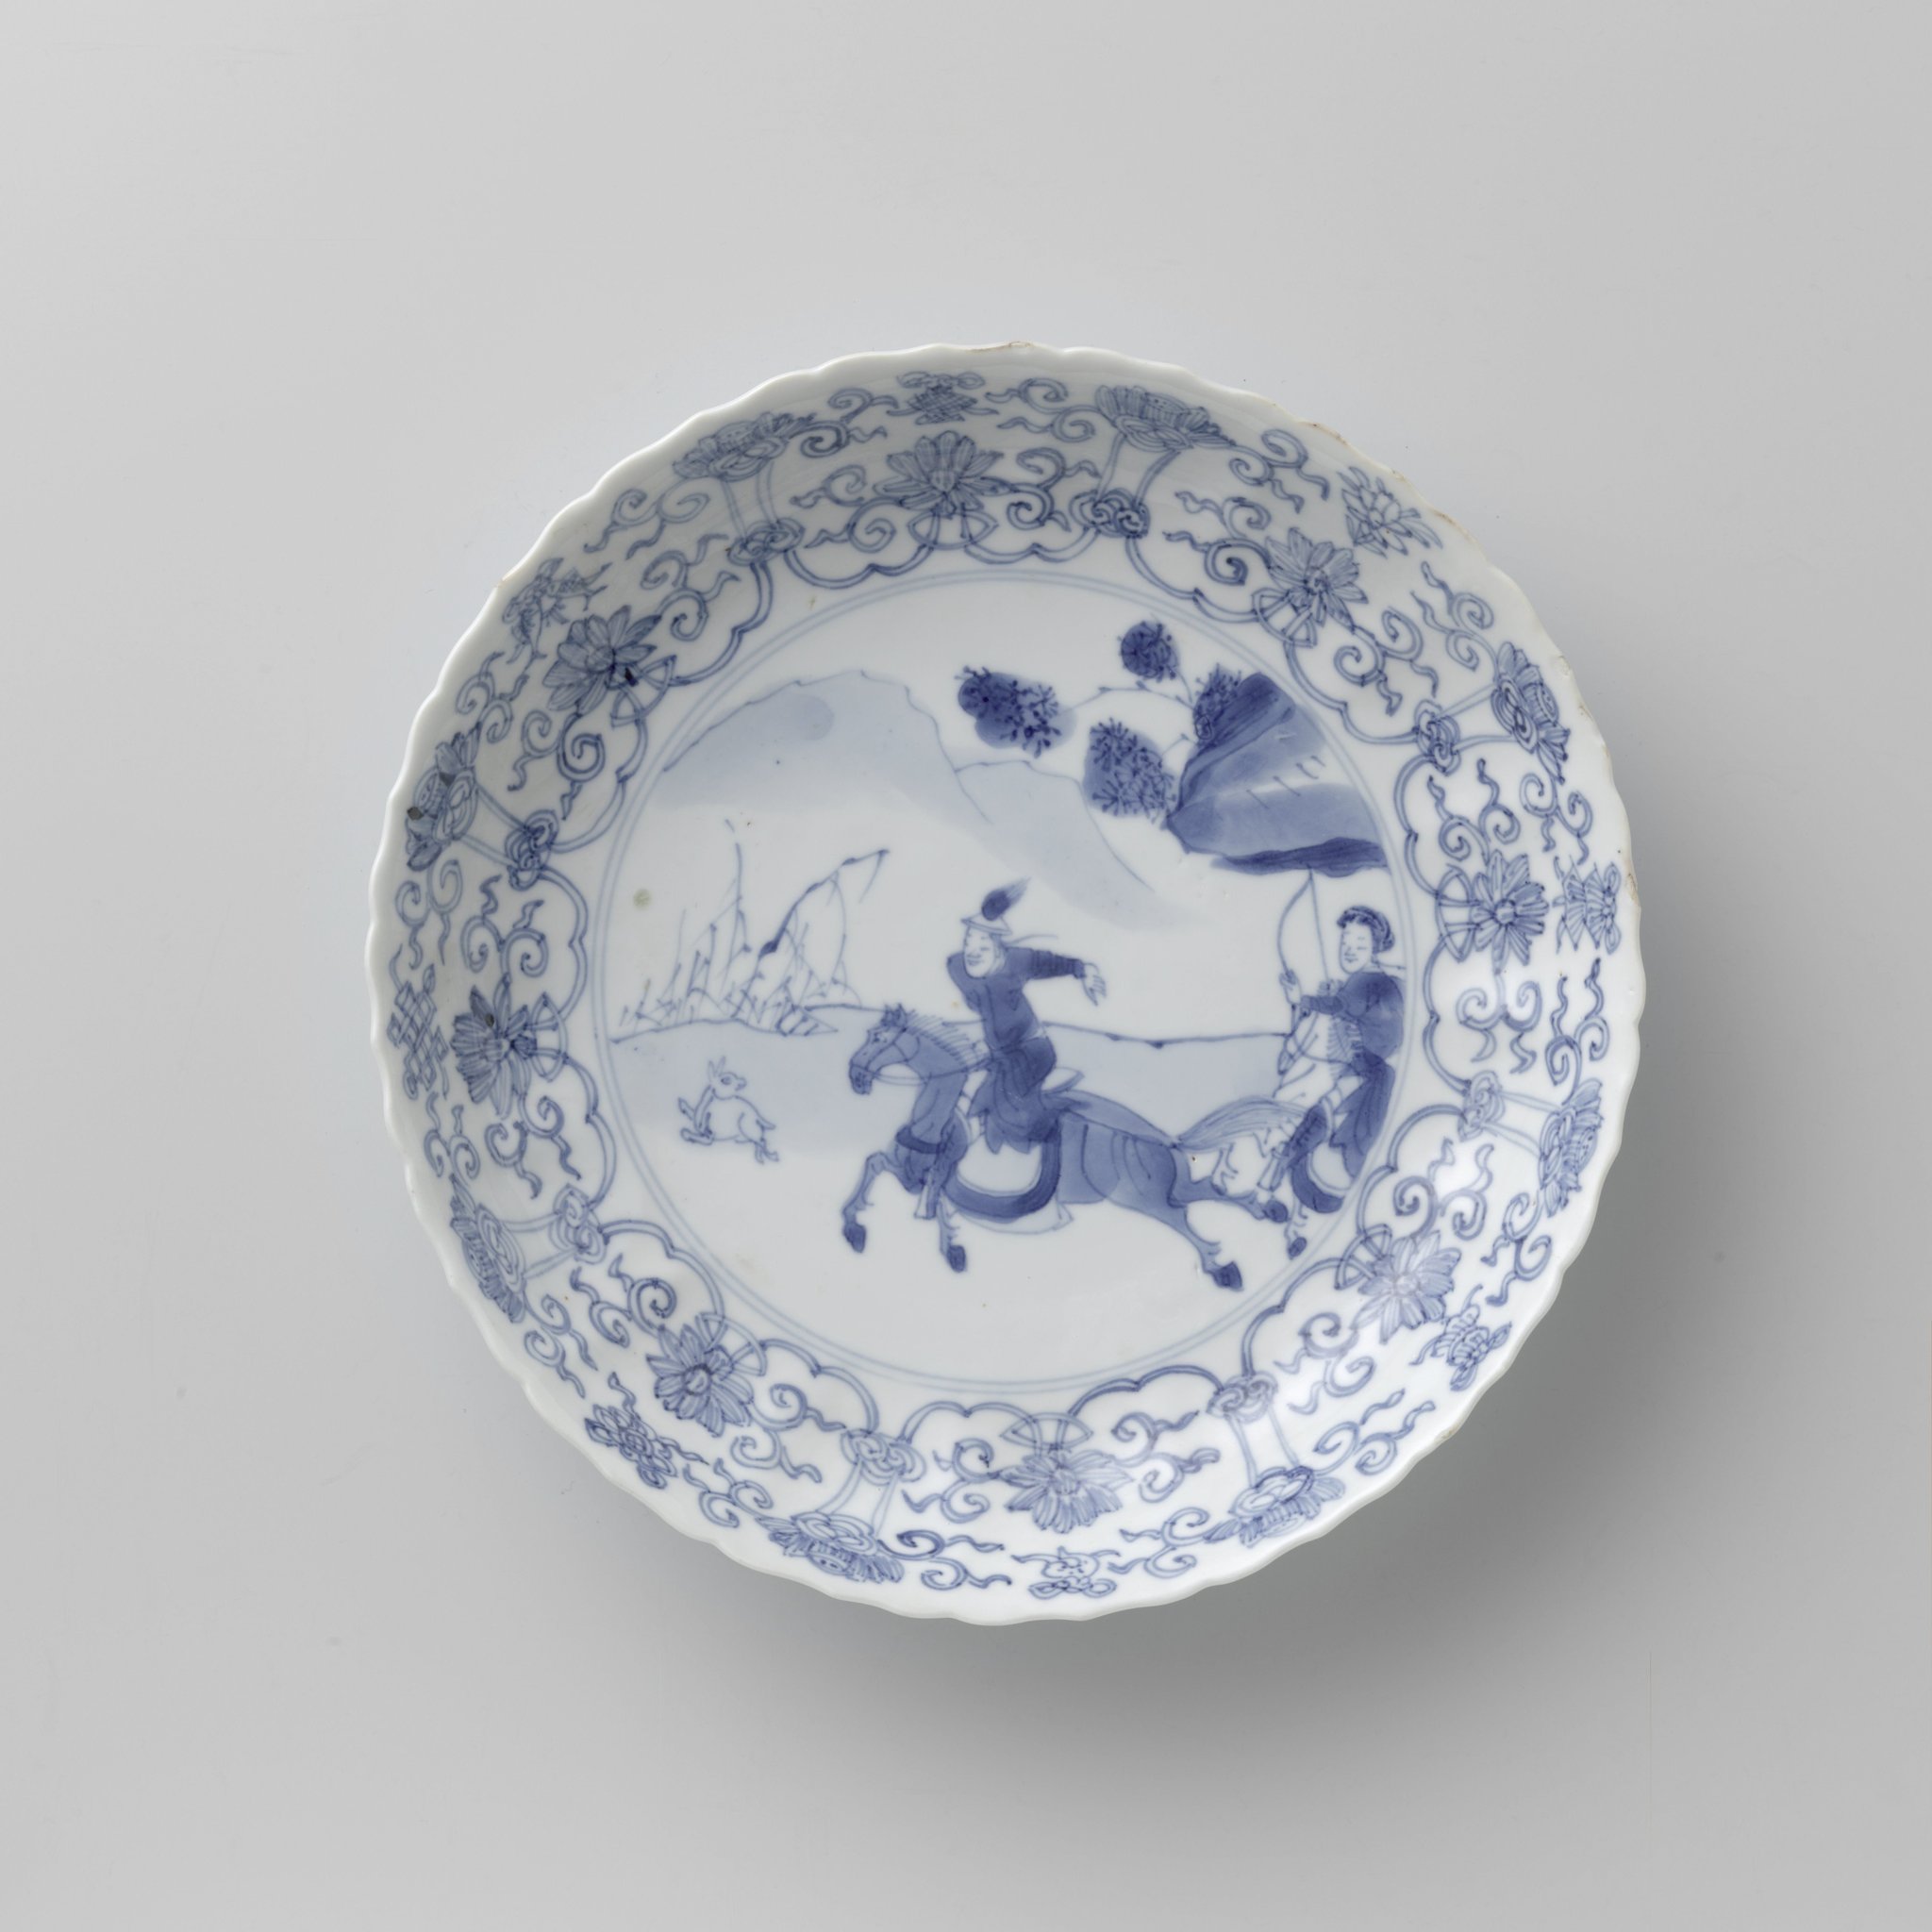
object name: dish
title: Saucer-dish with hunting scene, lotus scrolls and auspicious symbols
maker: Anonymous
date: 1700-1724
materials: cobalt, glaze, paint, porcelain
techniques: firing, forming, turning, vitrification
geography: china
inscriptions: mark: ‘大 明 成 化 年 製’